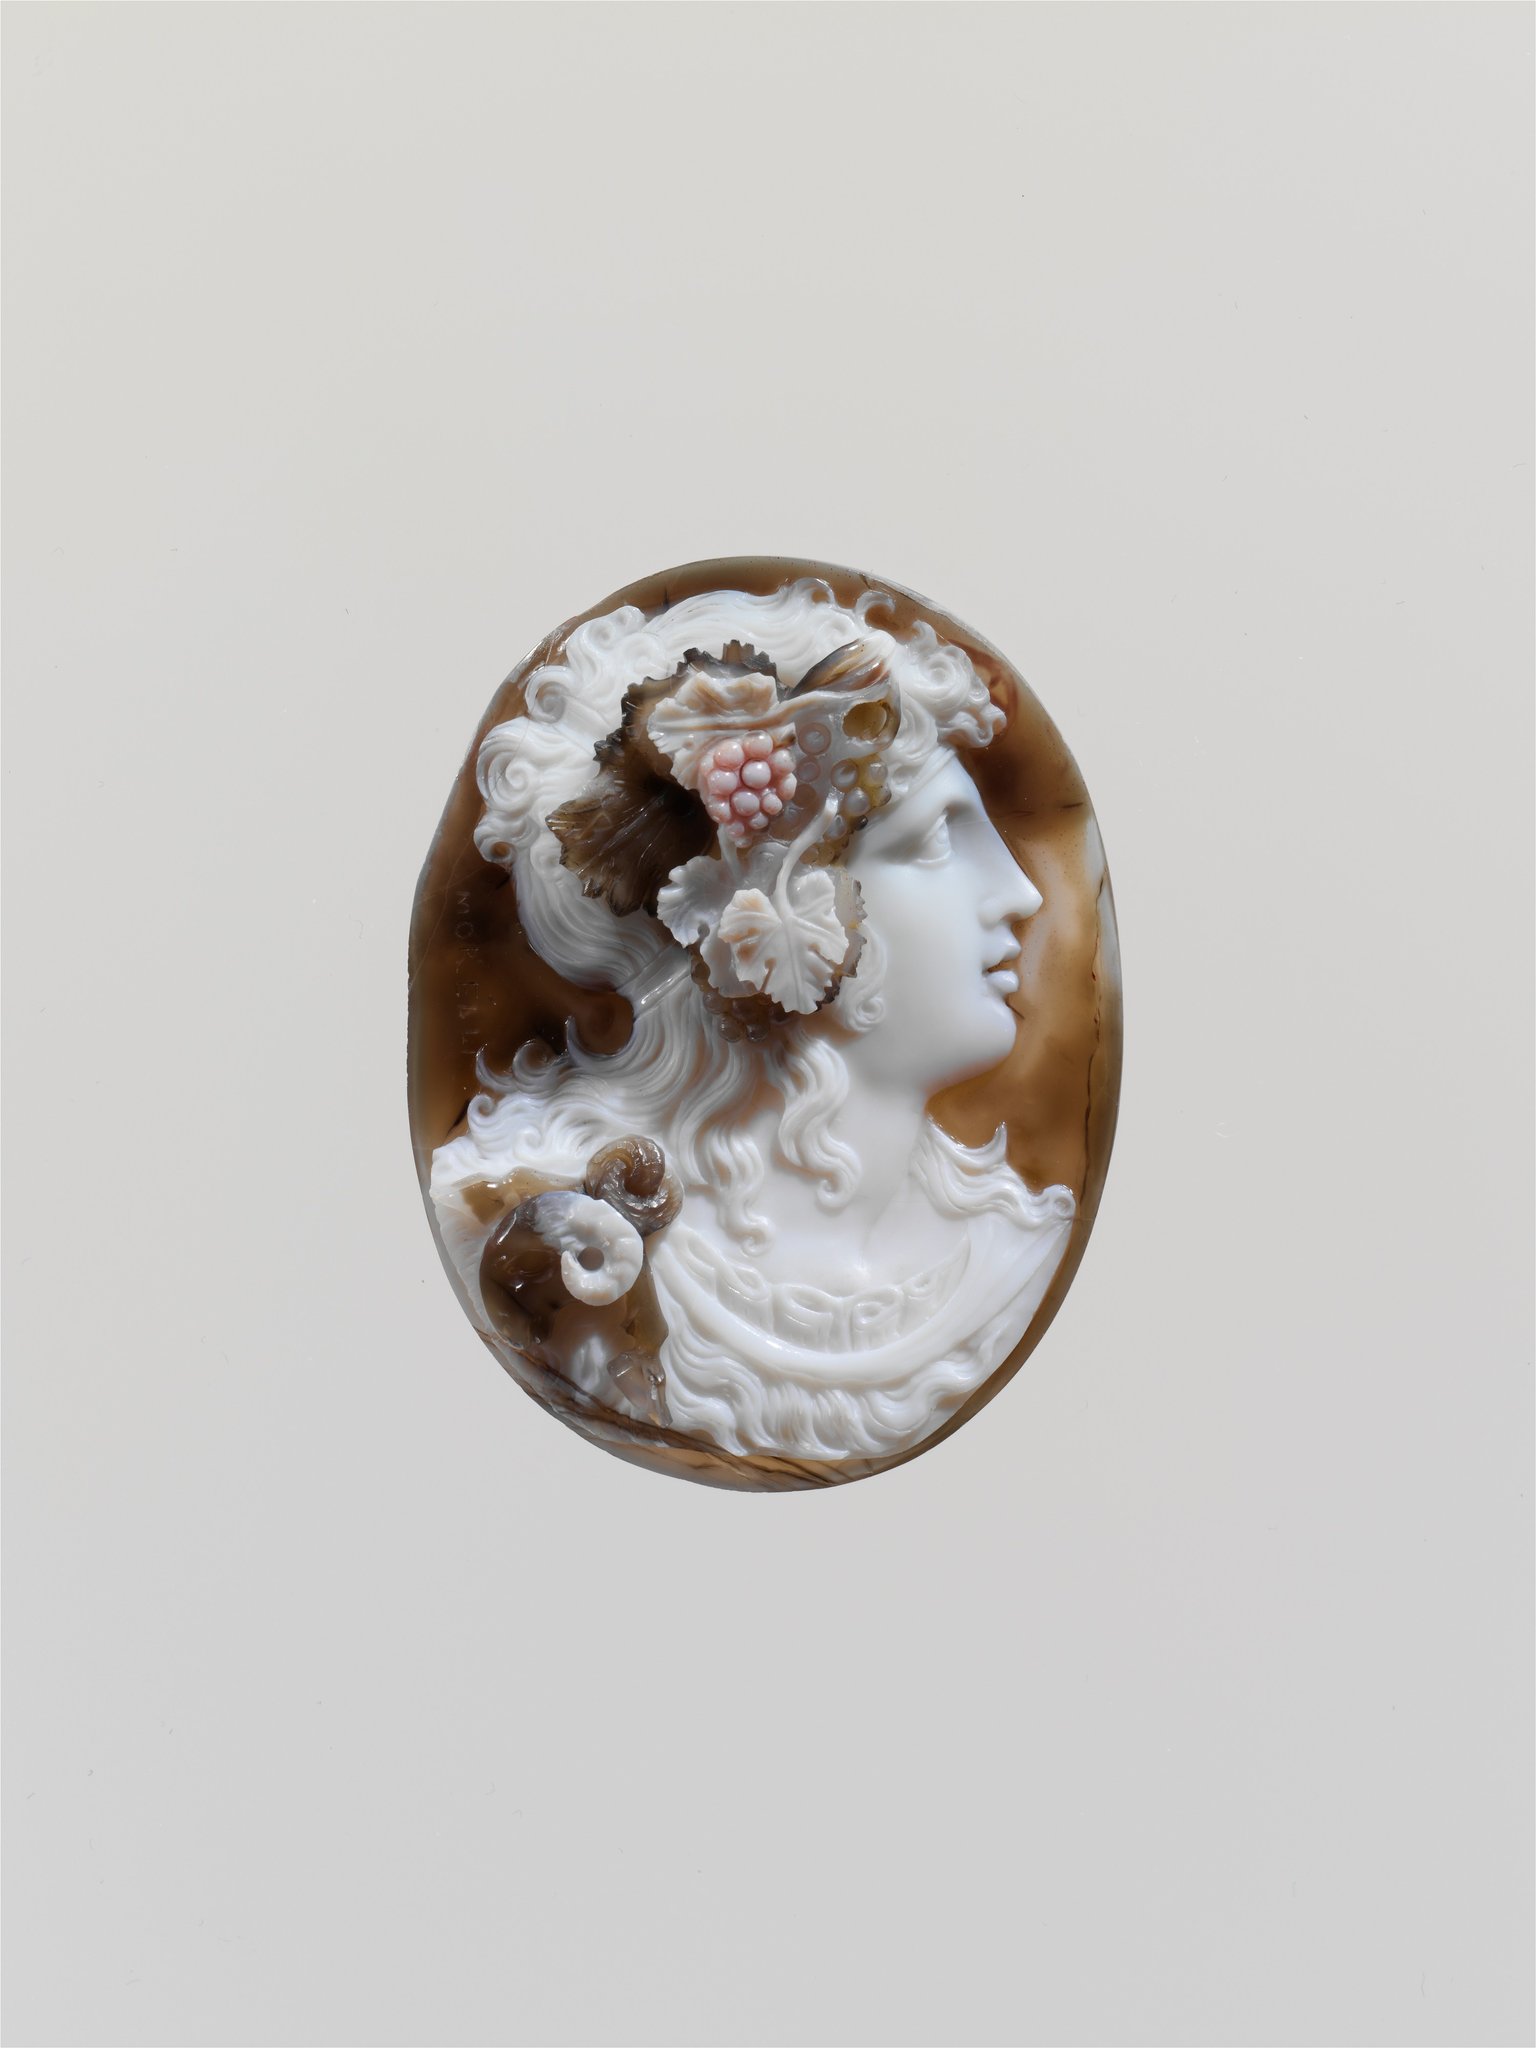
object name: cameo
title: Bust of a bacchante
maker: nicola morelli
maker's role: artist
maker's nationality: italian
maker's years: 1771-1838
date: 1820-1838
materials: onyx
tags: grapes,profiles,women